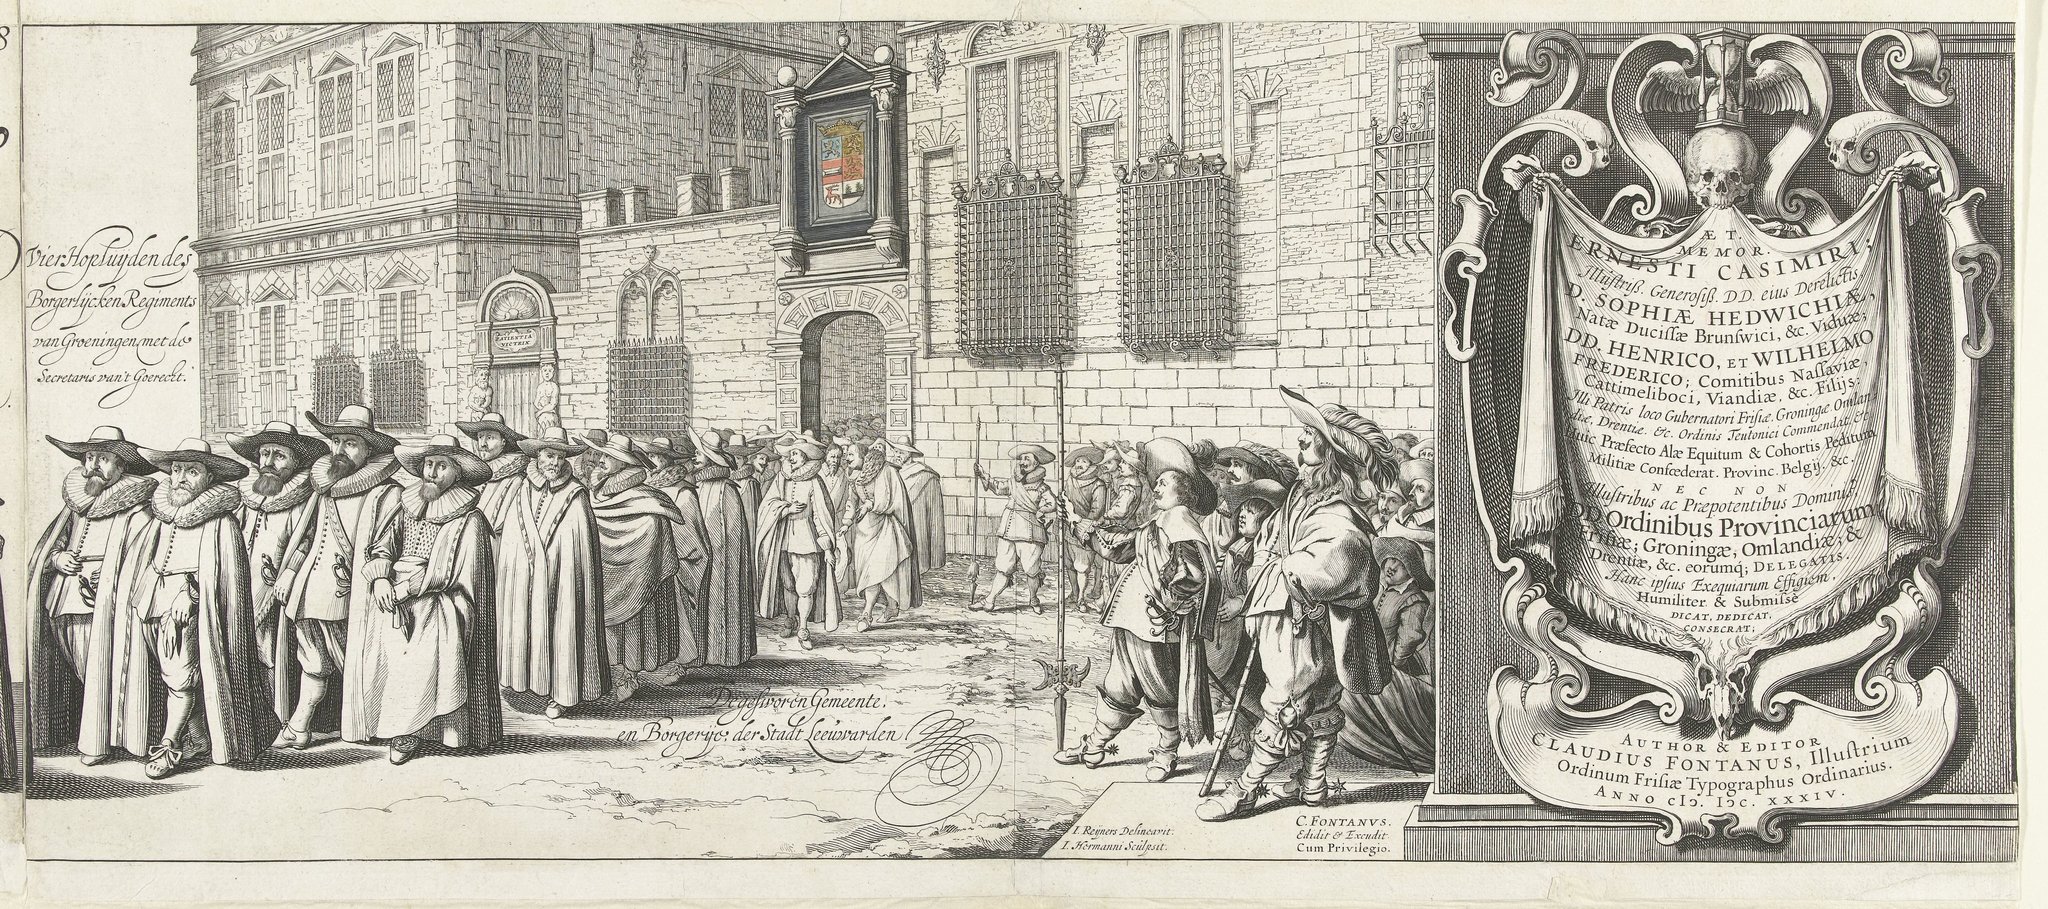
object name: print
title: Treur-Statighe Uyt-Vaert, ofte Begraeffenisse des ont-zielden Lichaems, van den On-vertsaeghden, ende seer Strijdtbaren Krijghs-Heldt, Ernest Casimyr (...) Overleden in de Belegheringhe voor Roermunde, door een Vyandtlijcke Koeghel (...) den vijff-en-twintichsten Maij, MDCXXXII. Begraven binnen Leeuwarden in 't Choor van de Iacobijner Kercke, den derden Ianuarij, MDCXXXIII. Oude Stijl.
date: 1634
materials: paper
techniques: engraving, etching, hand coloring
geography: northern netherlands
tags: ernst casimir graaf van nassau-dietz, cortege, funeral procession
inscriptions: date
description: Deel van de begrafenisstoet met burgers van de stad Leeuwarden. Het vertrek van de stoet vanuit het stadhuis. Rechts een cartouche met een hangende doek met tekst in het Latijn. Plaat nr. 20 in de prentserie van de begrafenis van Ernst Casimir, graaf van Nassau-Dietz te Leeuwarden, 3 januari 1633. De wapens en vaandels zijn ingekleurd. Dit blad samen met bladen 17, 18 en 20 aan elkaar geplakt.